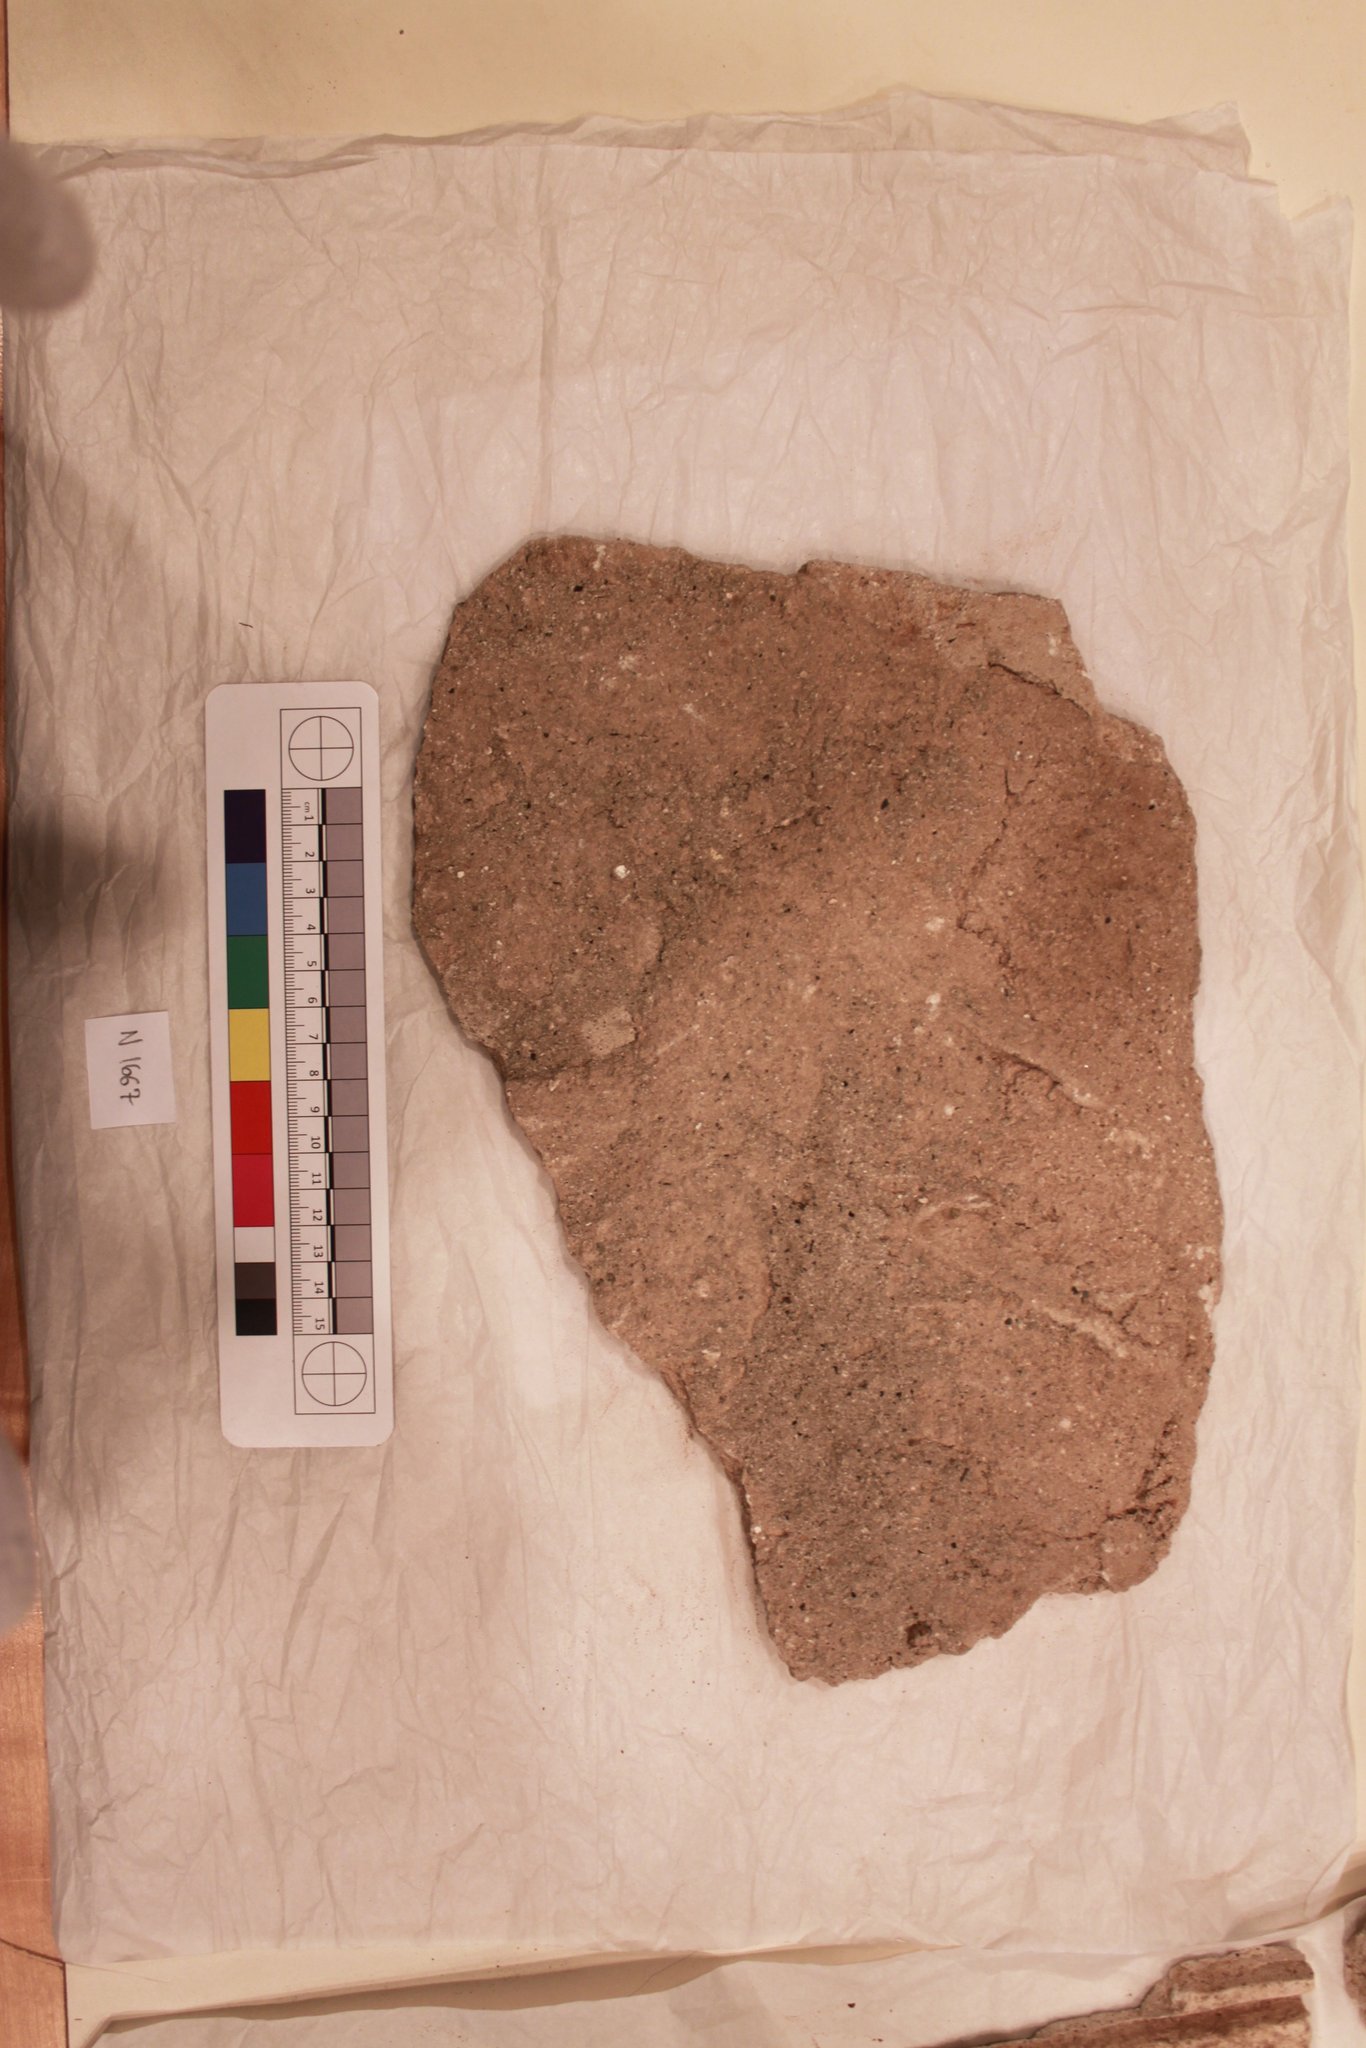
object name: fragment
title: Stucco Fragment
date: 701-1200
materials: plaster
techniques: carving, painting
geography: iran